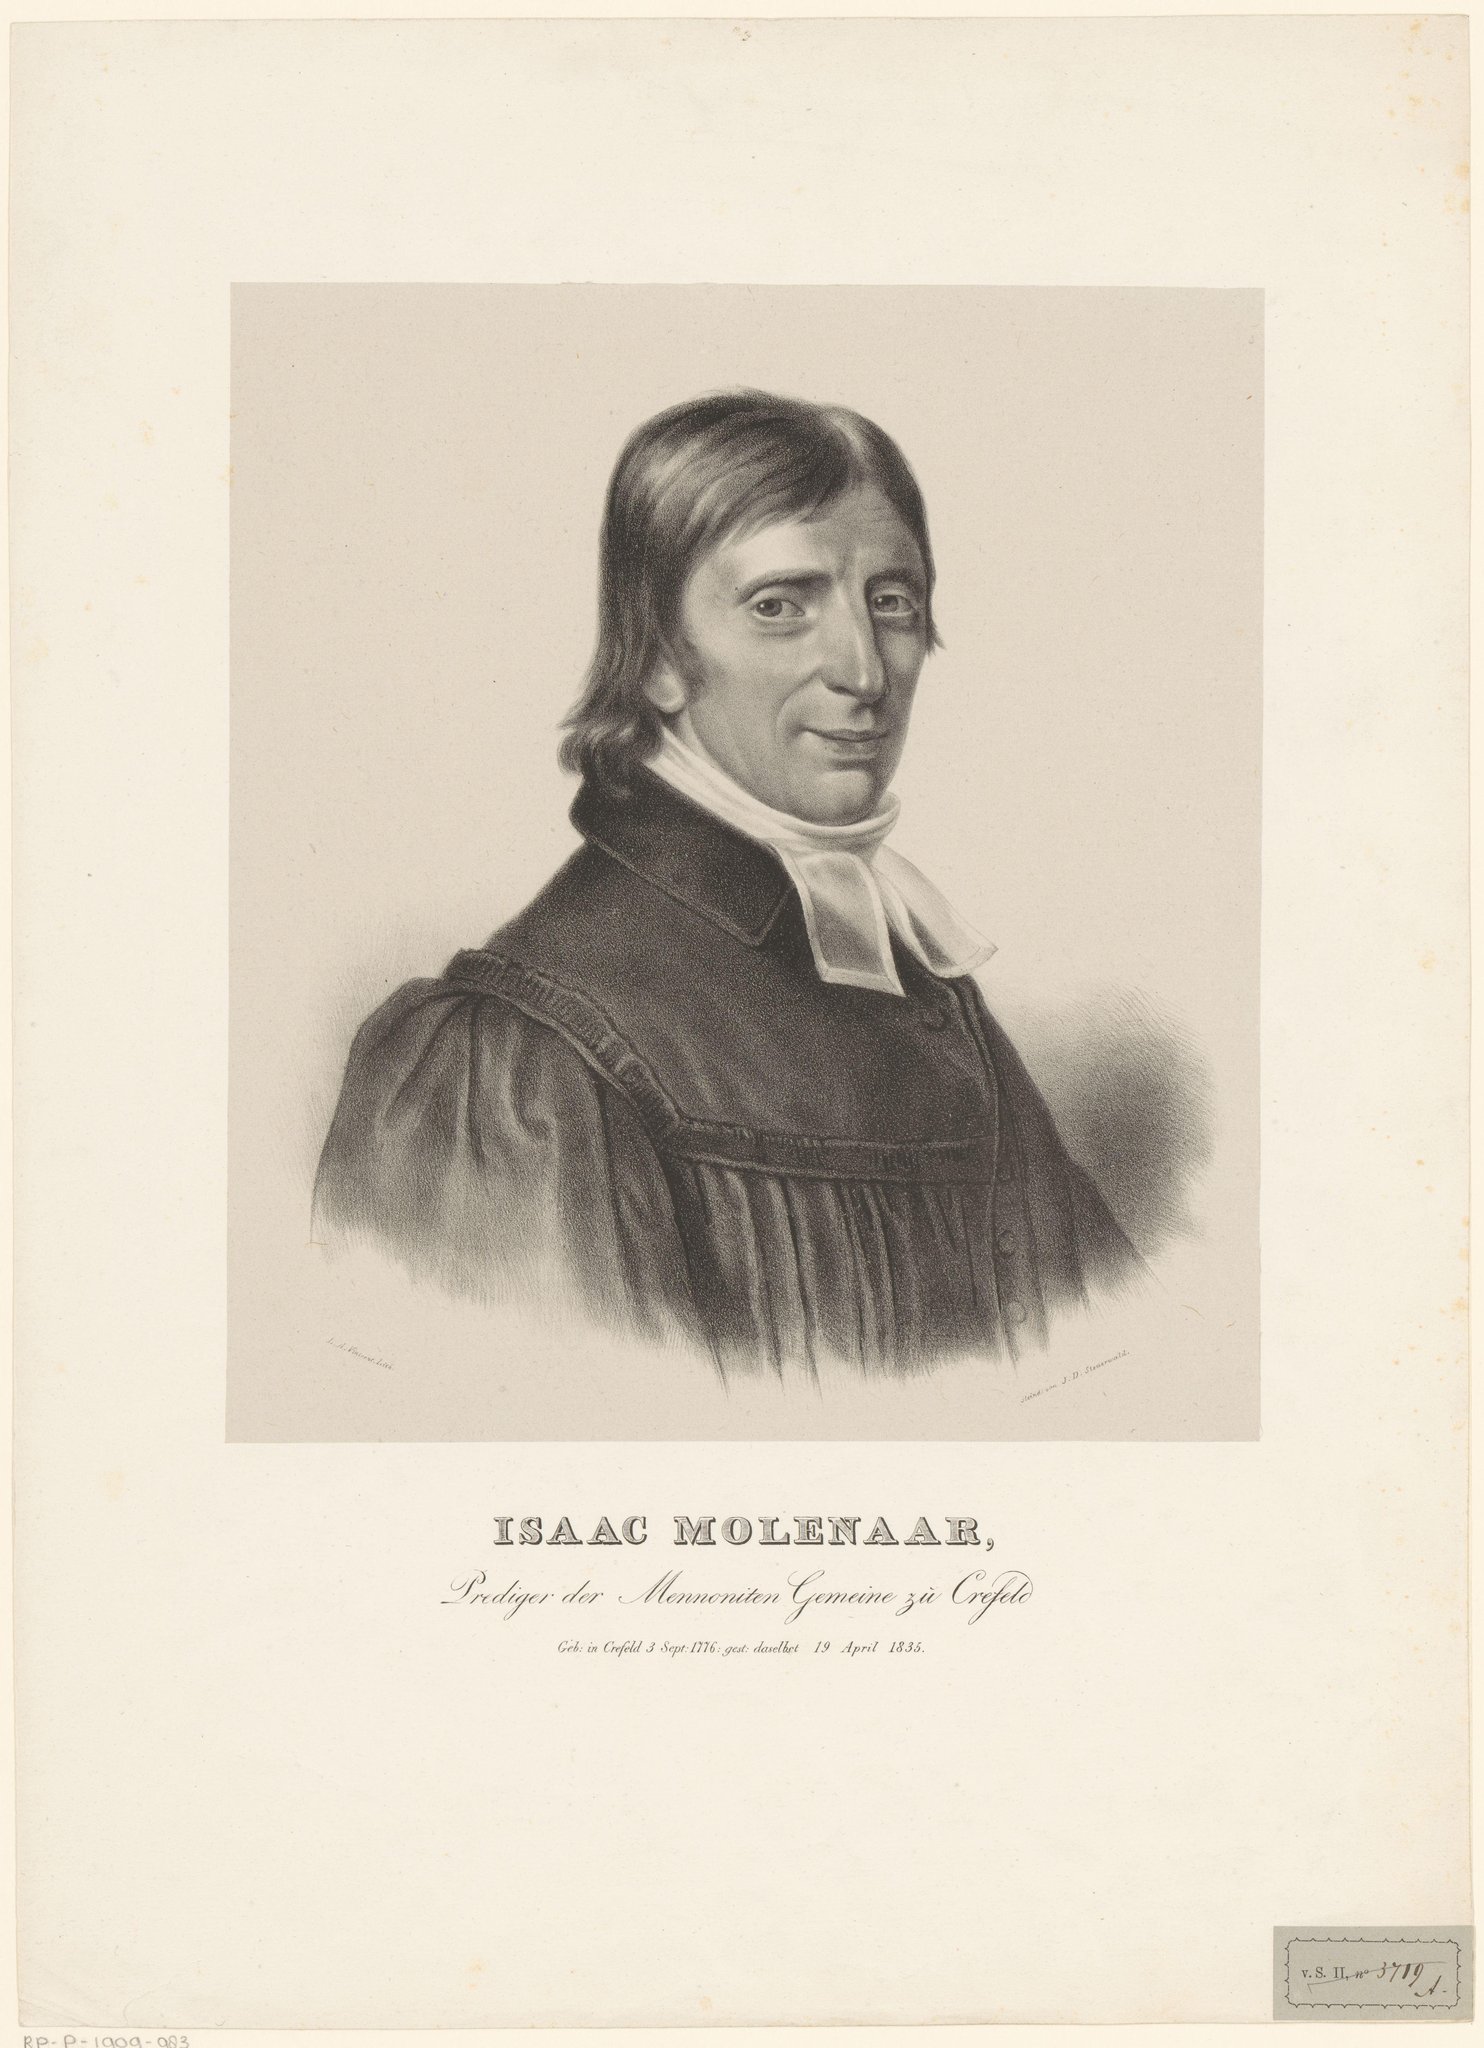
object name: print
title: Portret van Isaac Molenaar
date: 1835-1842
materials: paper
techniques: lithograph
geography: the hague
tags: historical persons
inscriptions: collector's mark: Lugt 2228